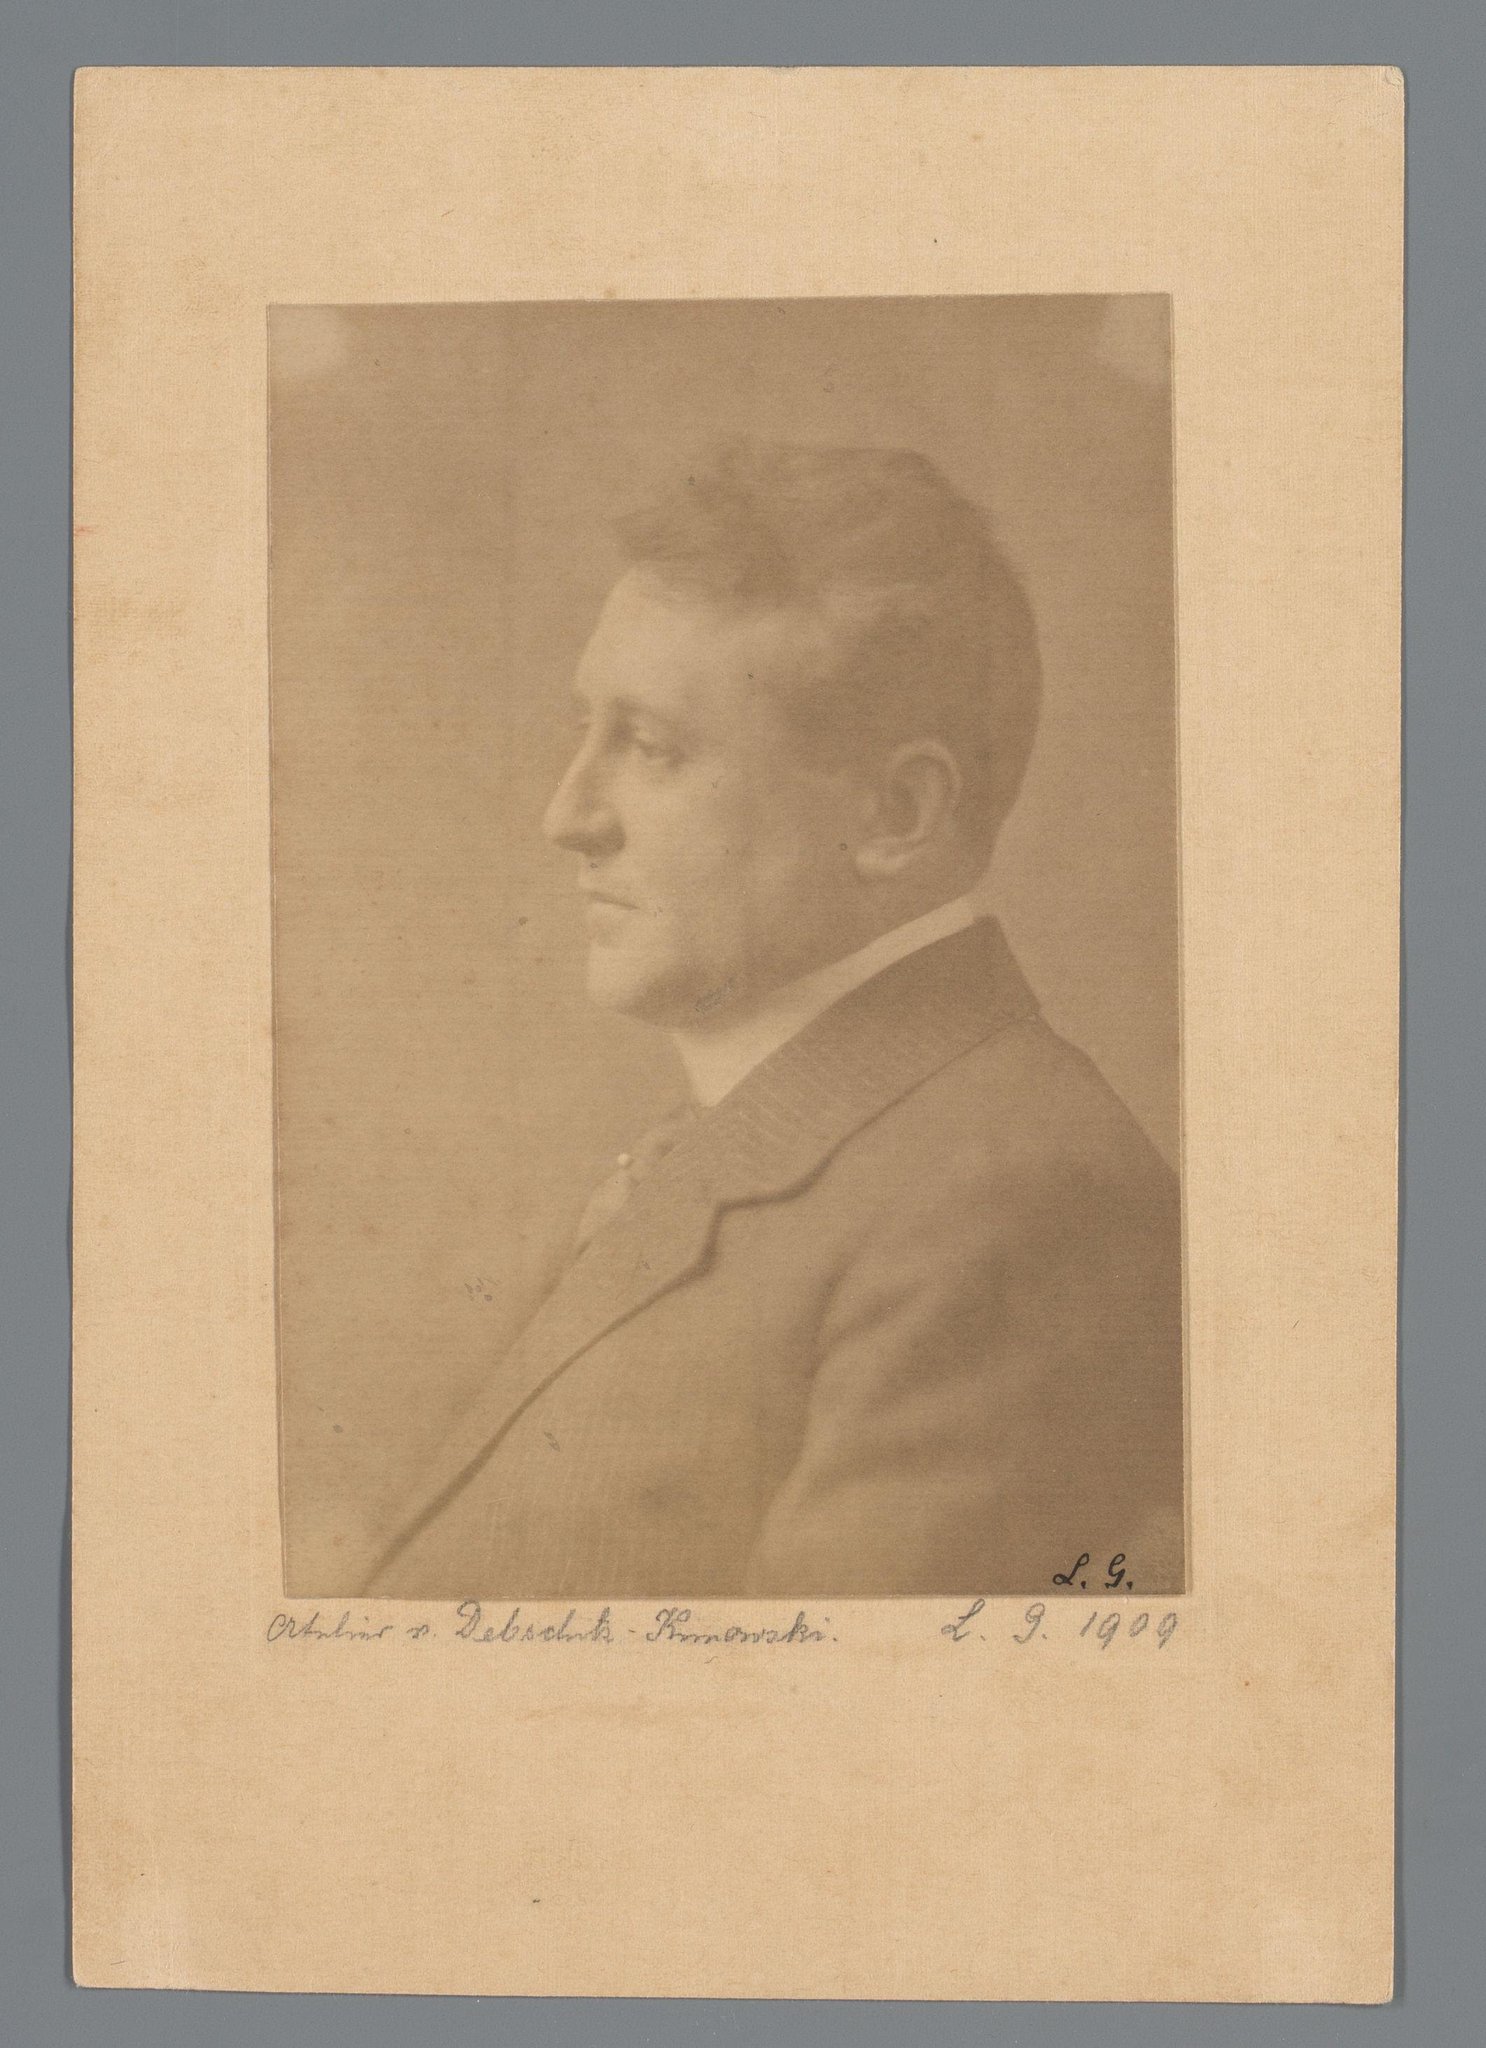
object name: photograph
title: Portret van Jean Buysson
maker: wanda von debschitz-kunowski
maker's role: fotograaf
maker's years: 1870-1935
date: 1909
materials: cardboard, paper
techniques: albumen print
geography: munich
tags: paris, historical persons (portraits and scenes from the life)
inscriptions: inscription: ‘L.G.’, number: ‘No 1’